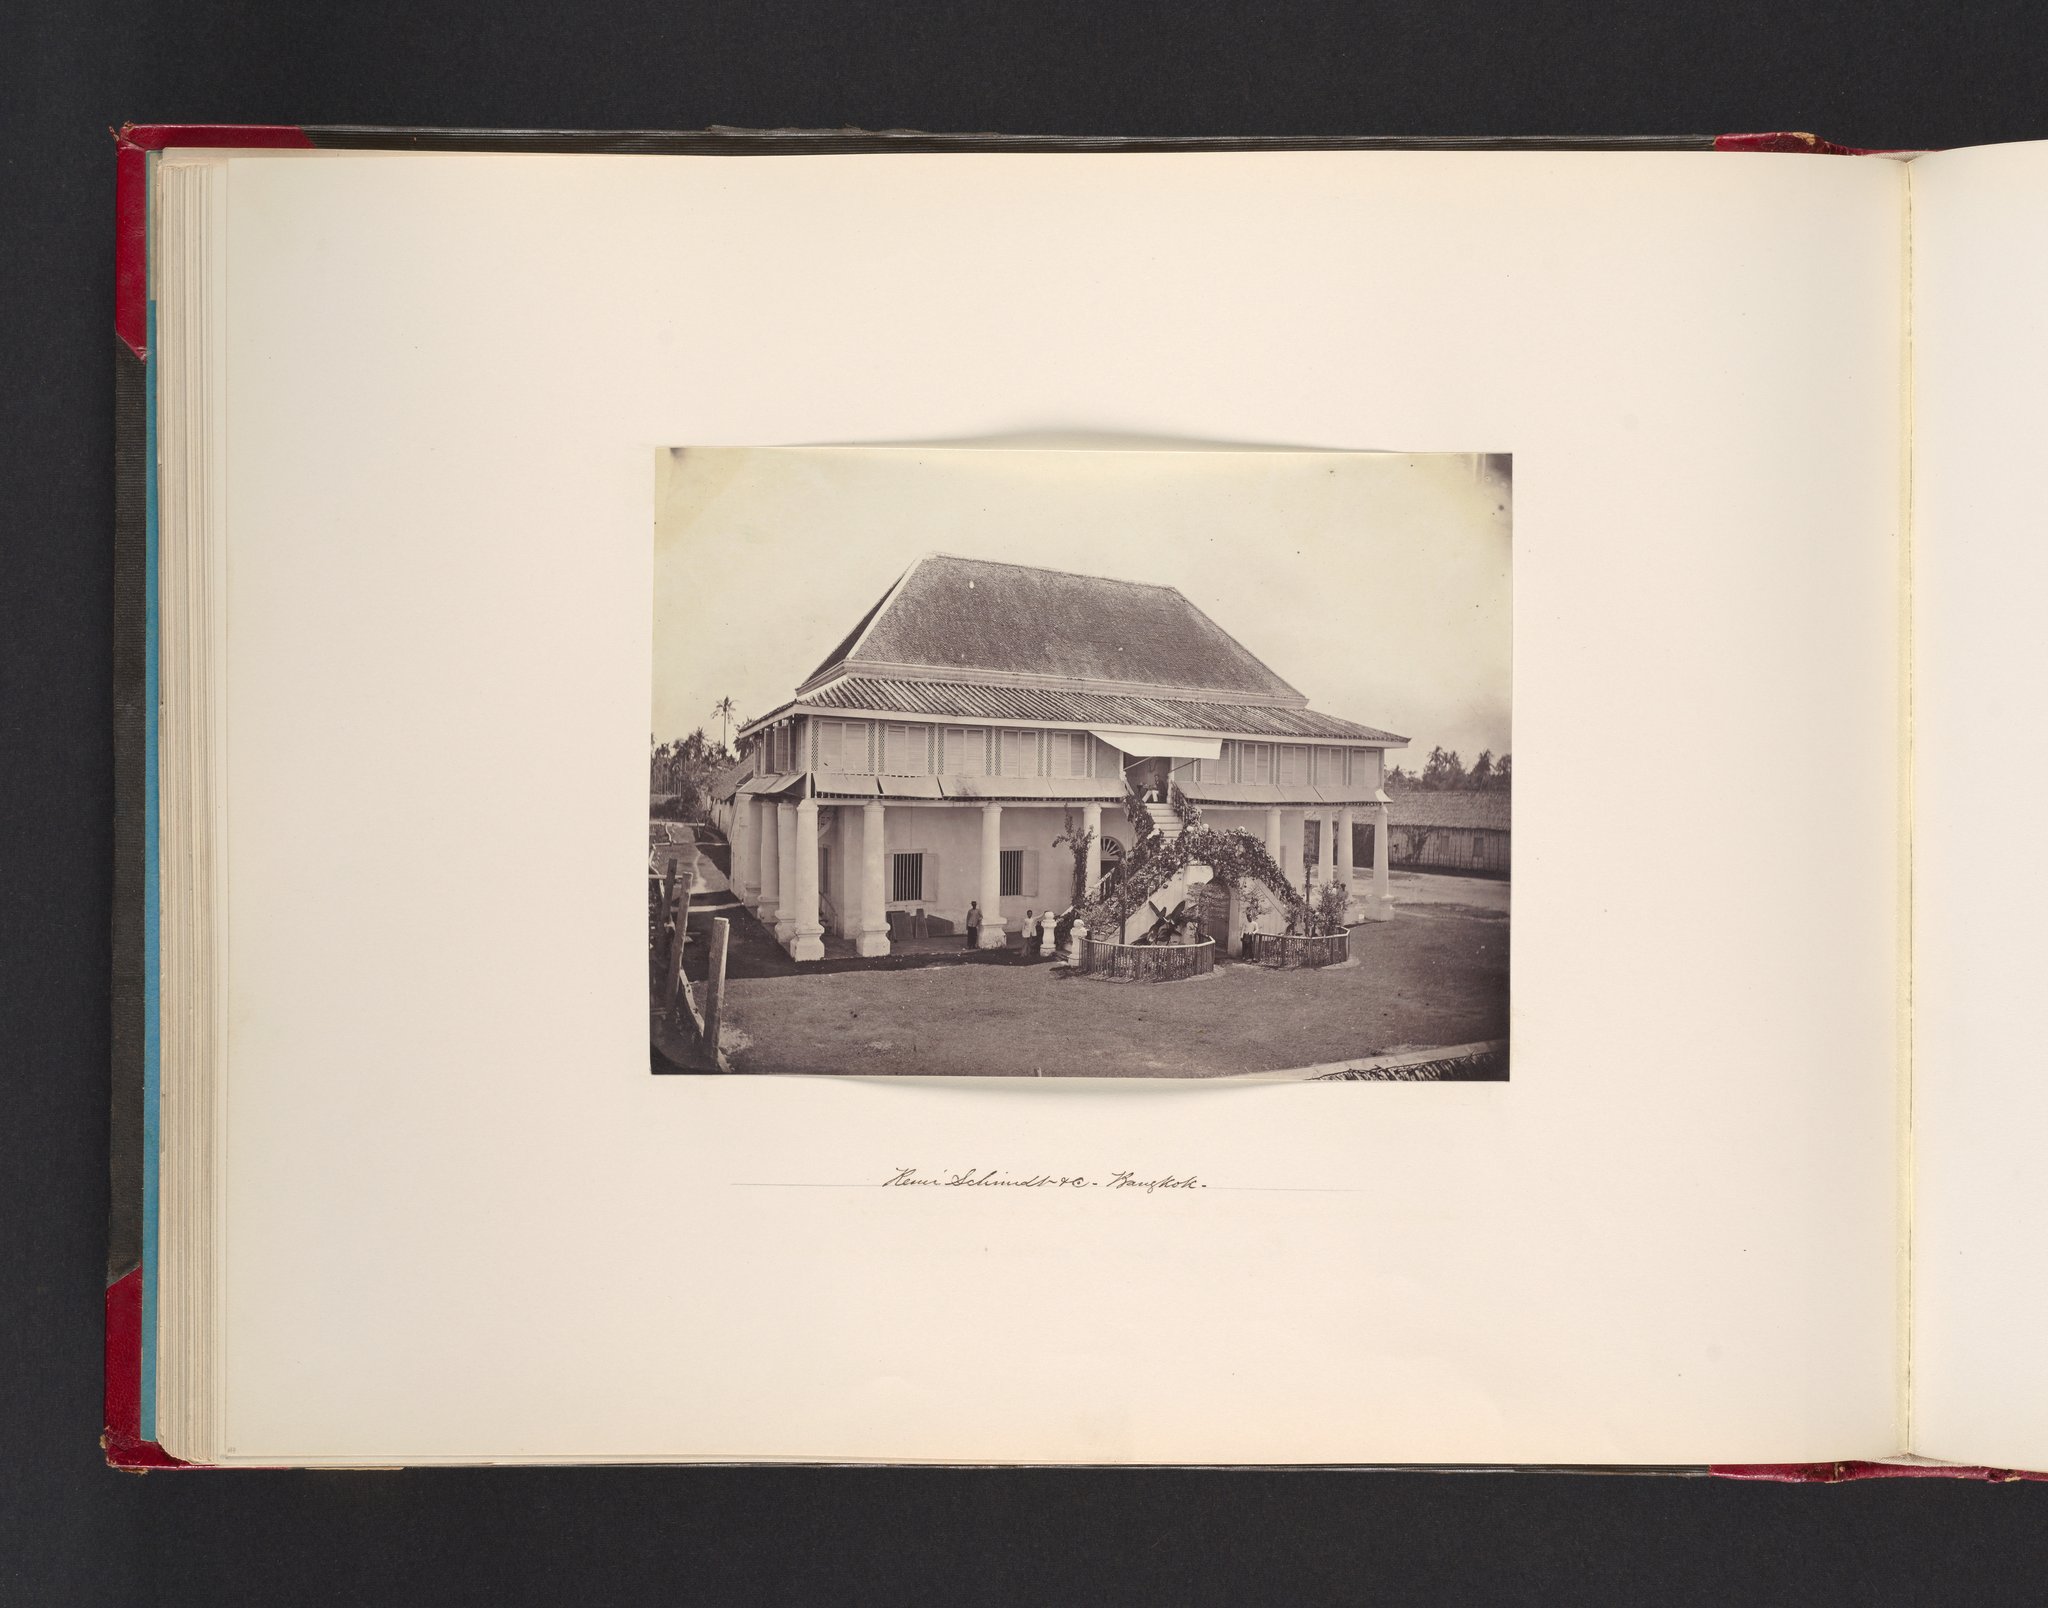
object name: photograph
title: Remi Schmidt & Co., Bangkok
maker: john thomson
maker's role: artist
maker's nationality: british, scottish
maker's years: 1837-1921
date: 1865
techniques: albumen silver print, glass negative